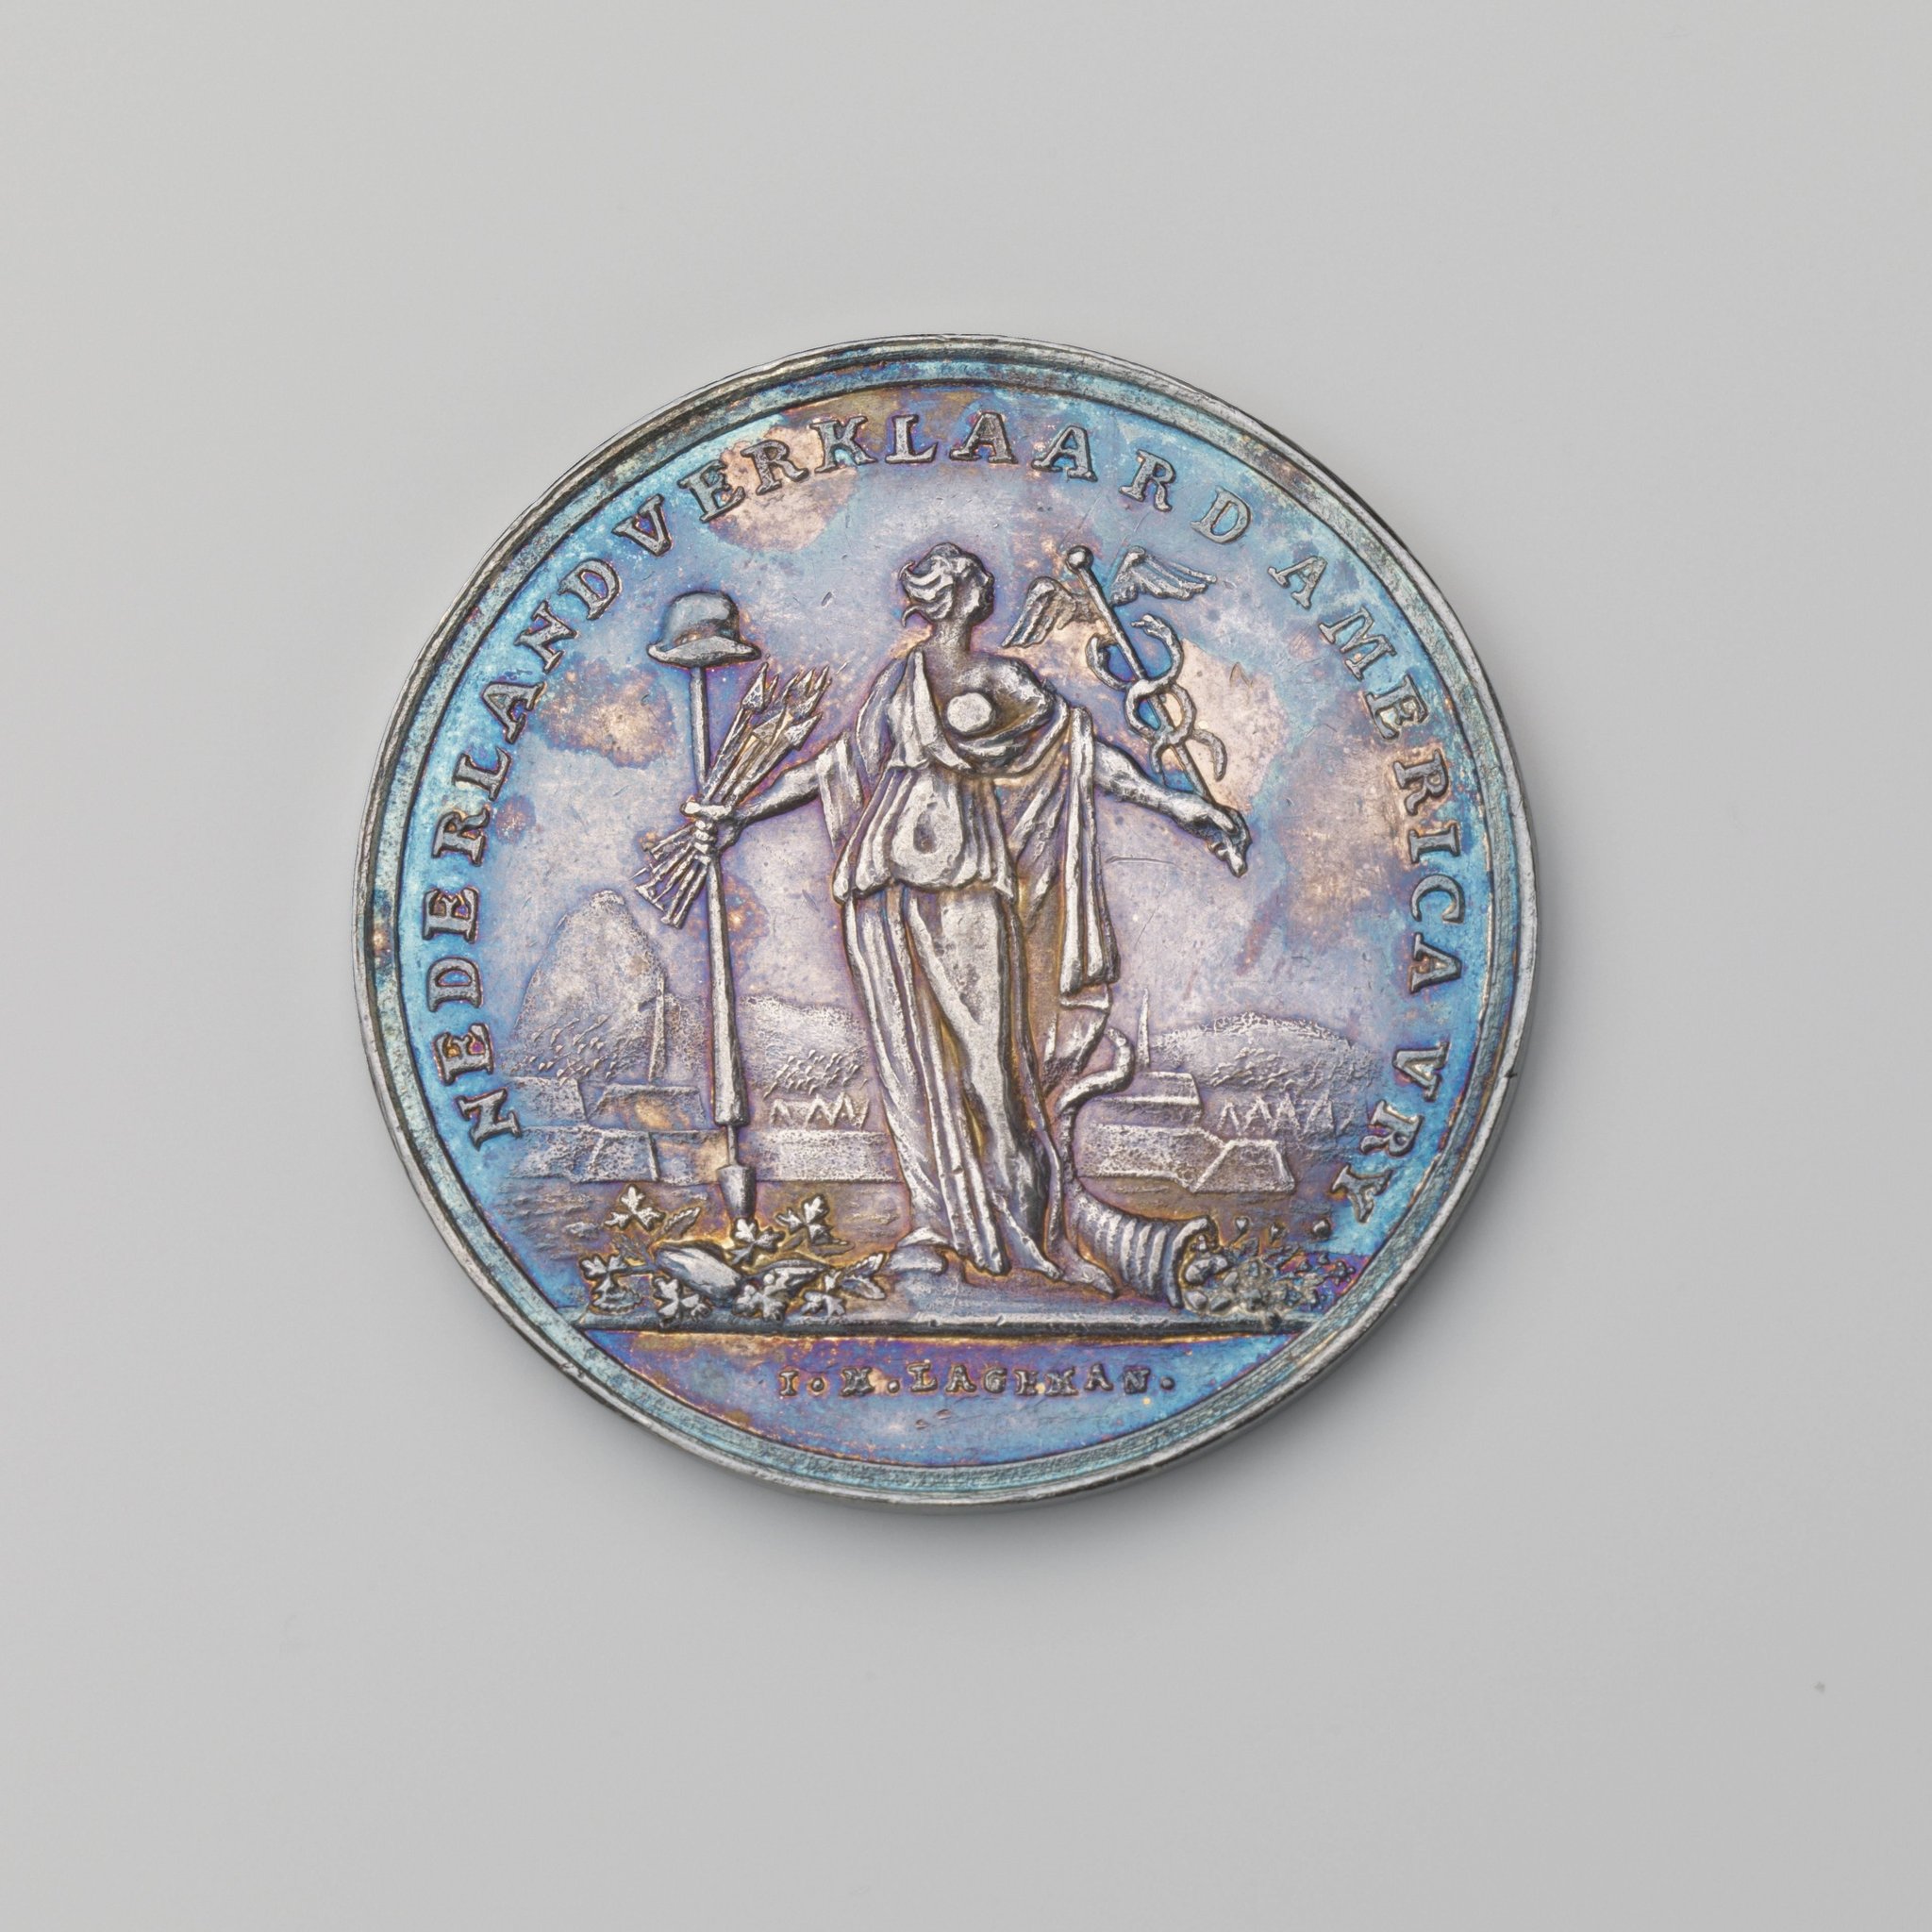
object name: history medal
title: Erkenning van de onafhankelijkheid van de Verenigde Staten van Amerika door de Staten-Generaal der Nederlanden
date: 1782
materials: silver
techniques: striking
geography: amsterdam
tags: united states of america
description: Medal, after a design by I.M. Lageman, struck in 1782 to mark the States General's recognation of John Adams as representative of the United States in the Republic.